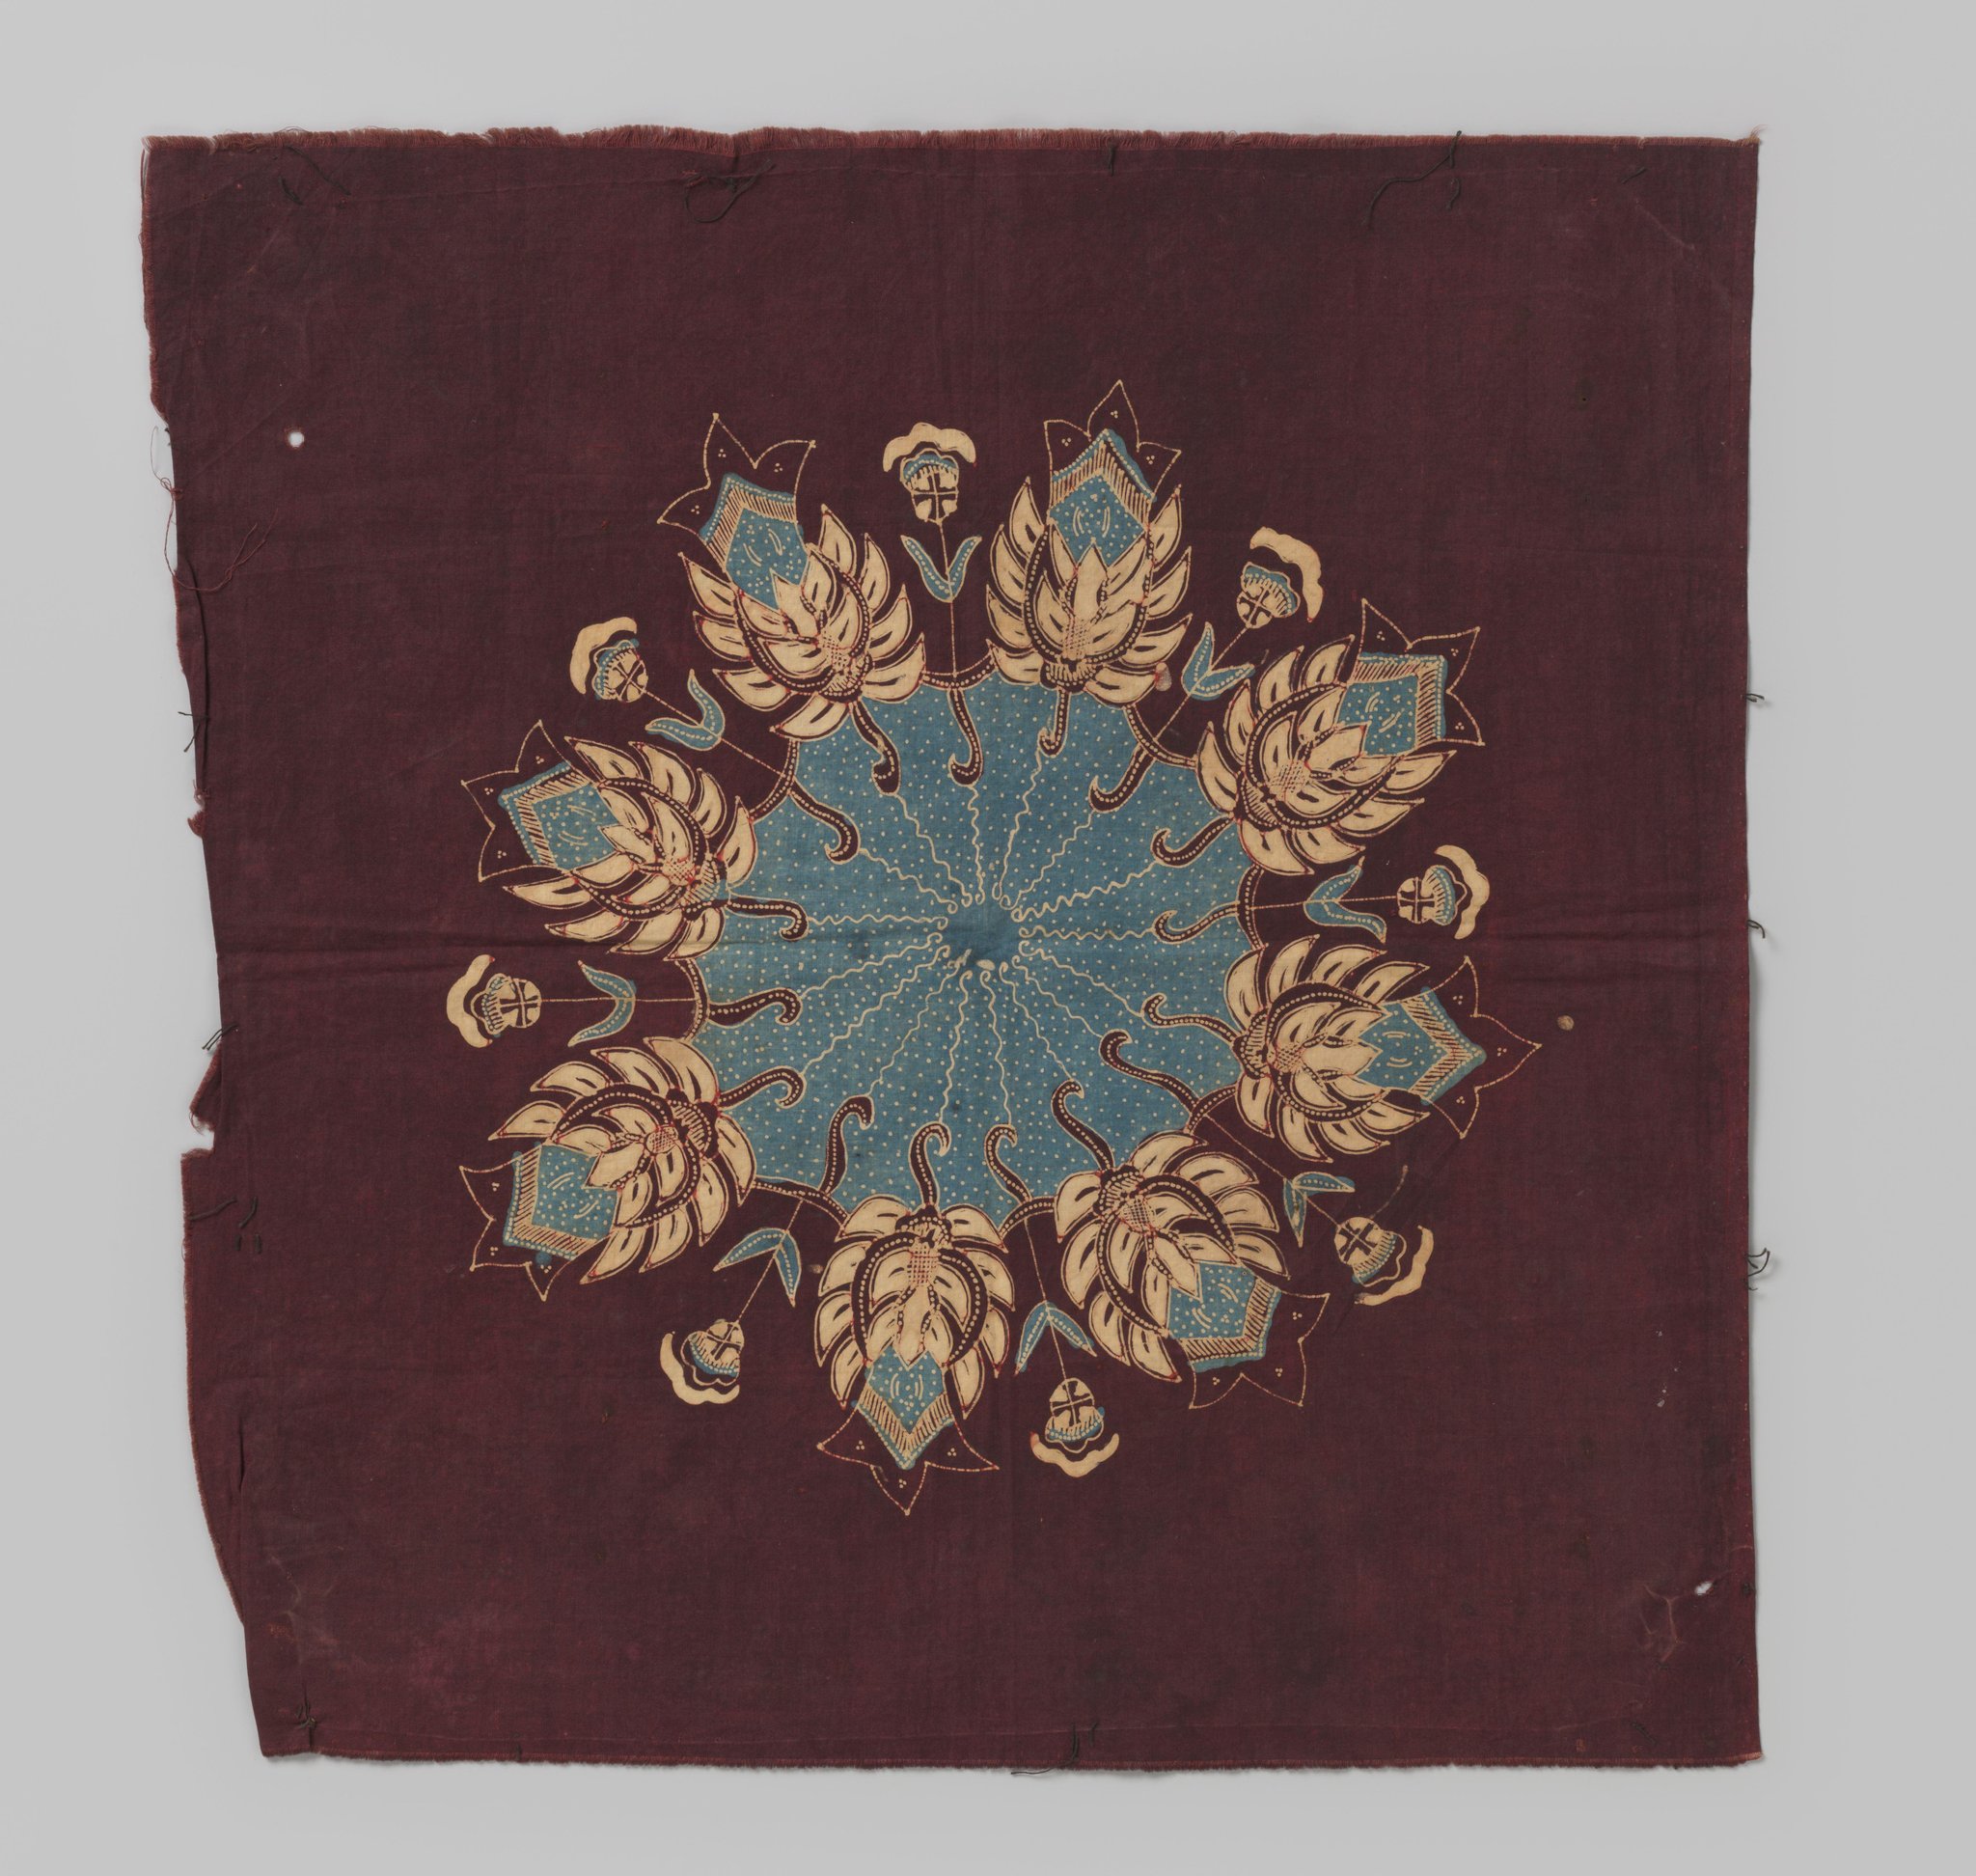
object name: sierdoek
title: Gebatikte sierdoek met gestileerd Oosters motief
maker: willem karel rees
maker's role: designer, painter, print maker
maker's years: 1880-1962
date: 1910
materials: cotton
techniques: batik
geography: haarlem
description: Gebatikte sierdoek van katoen met een Oosters dessin van een blauwe cirkel met stippen in écru waaromheen gestileerde bloemen in blauw en écru op een aubeginekleurig fond.